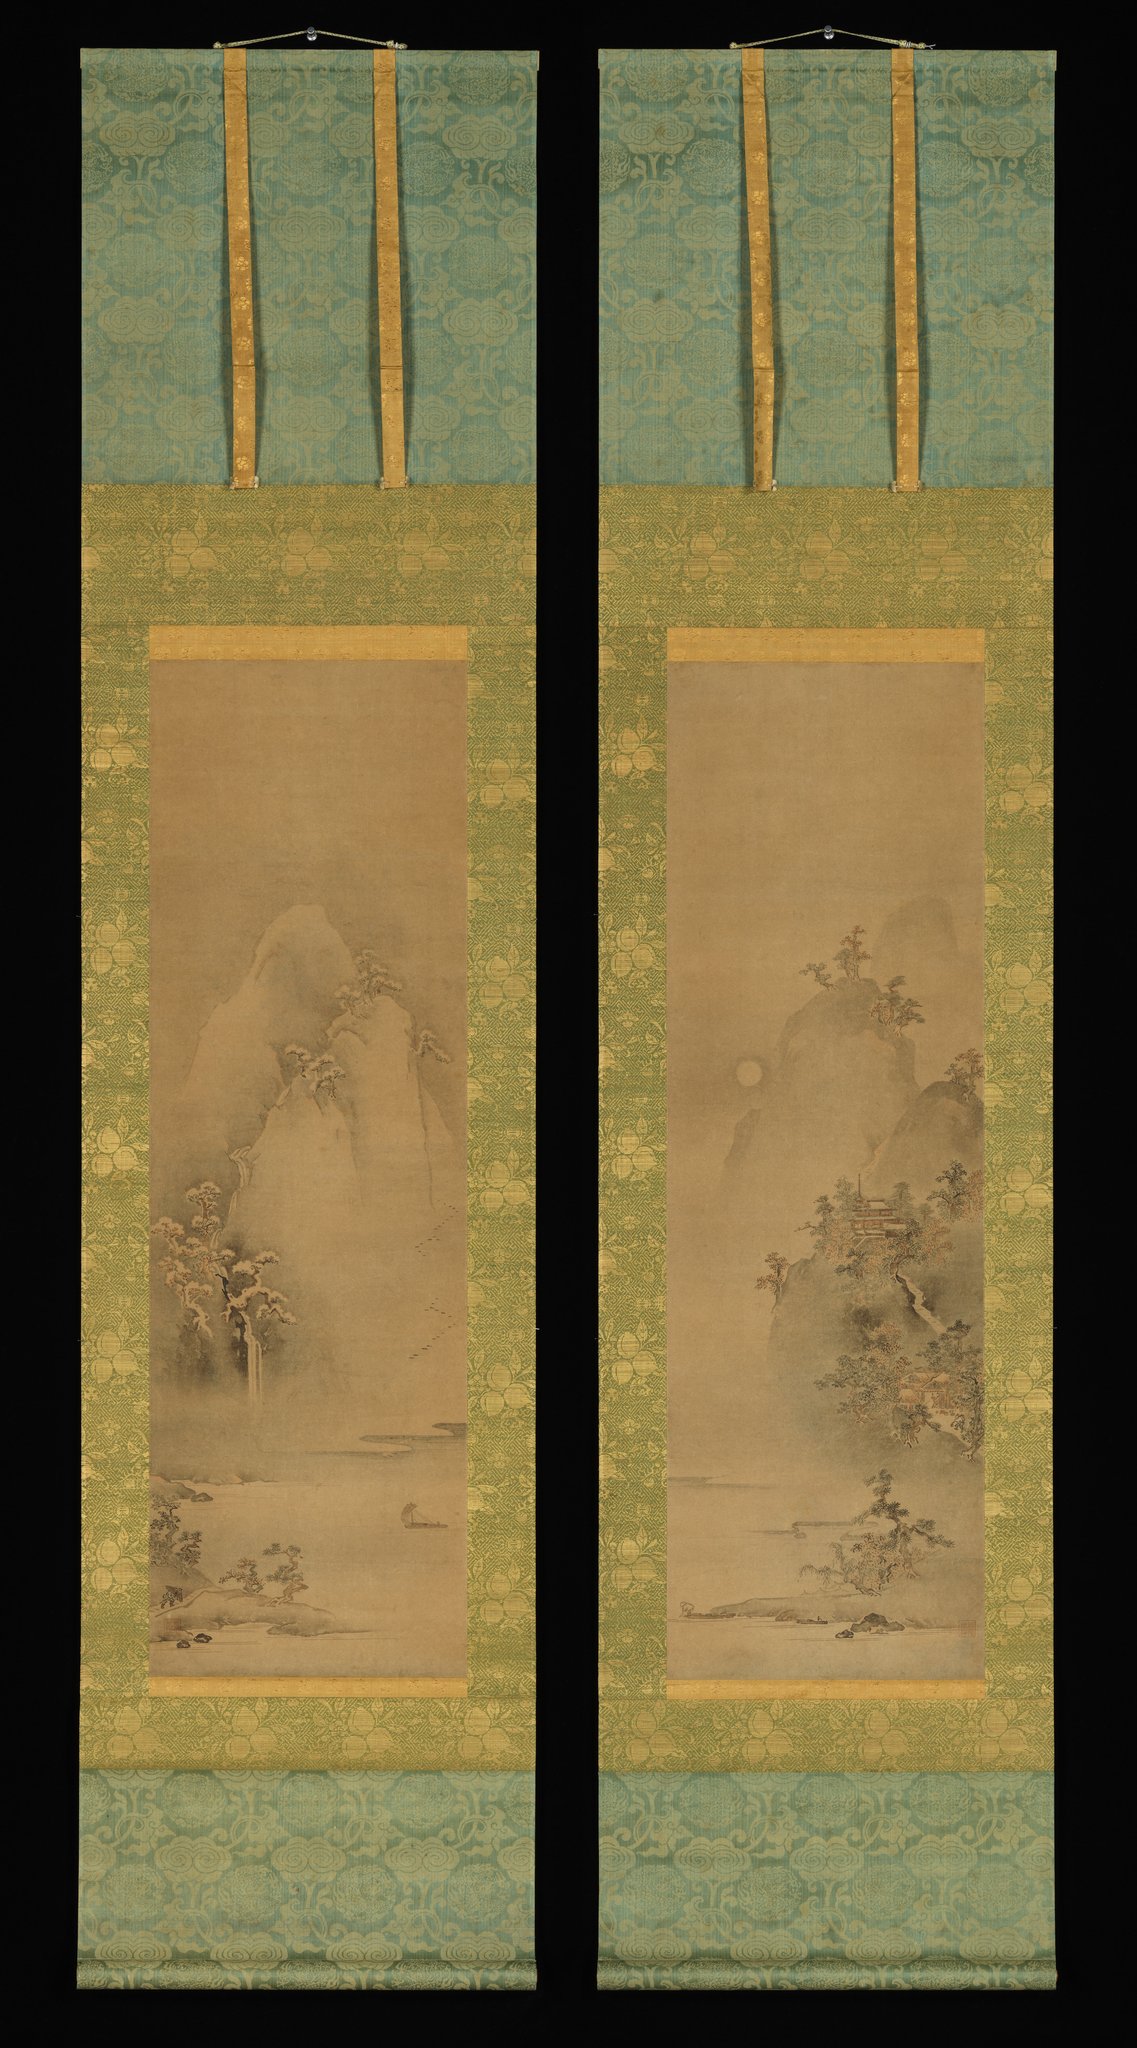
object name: hanging scroll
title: Eight Views of Xiao and Xiang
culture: japanese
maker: iwasa matabei (iwasa matabē) 岩佐又兵衛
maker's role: artist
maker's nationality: japanese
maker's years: 1578-1650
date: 1640-1649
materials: ink, paper